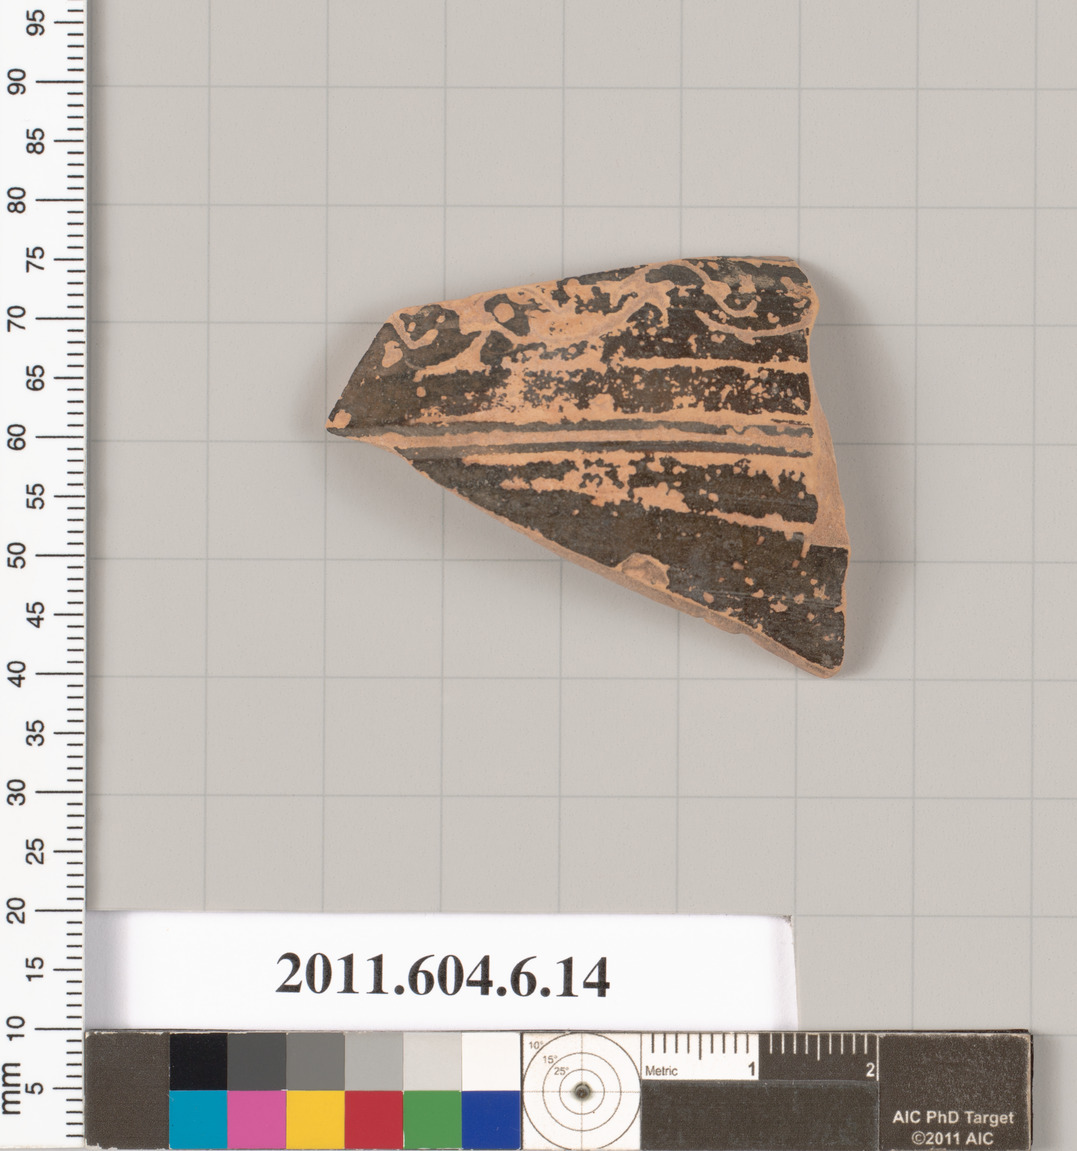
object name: undetermined shape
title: Terracotta fragment of an undetermined shape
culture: greek, attic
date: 600-401 BCE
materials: terracotta